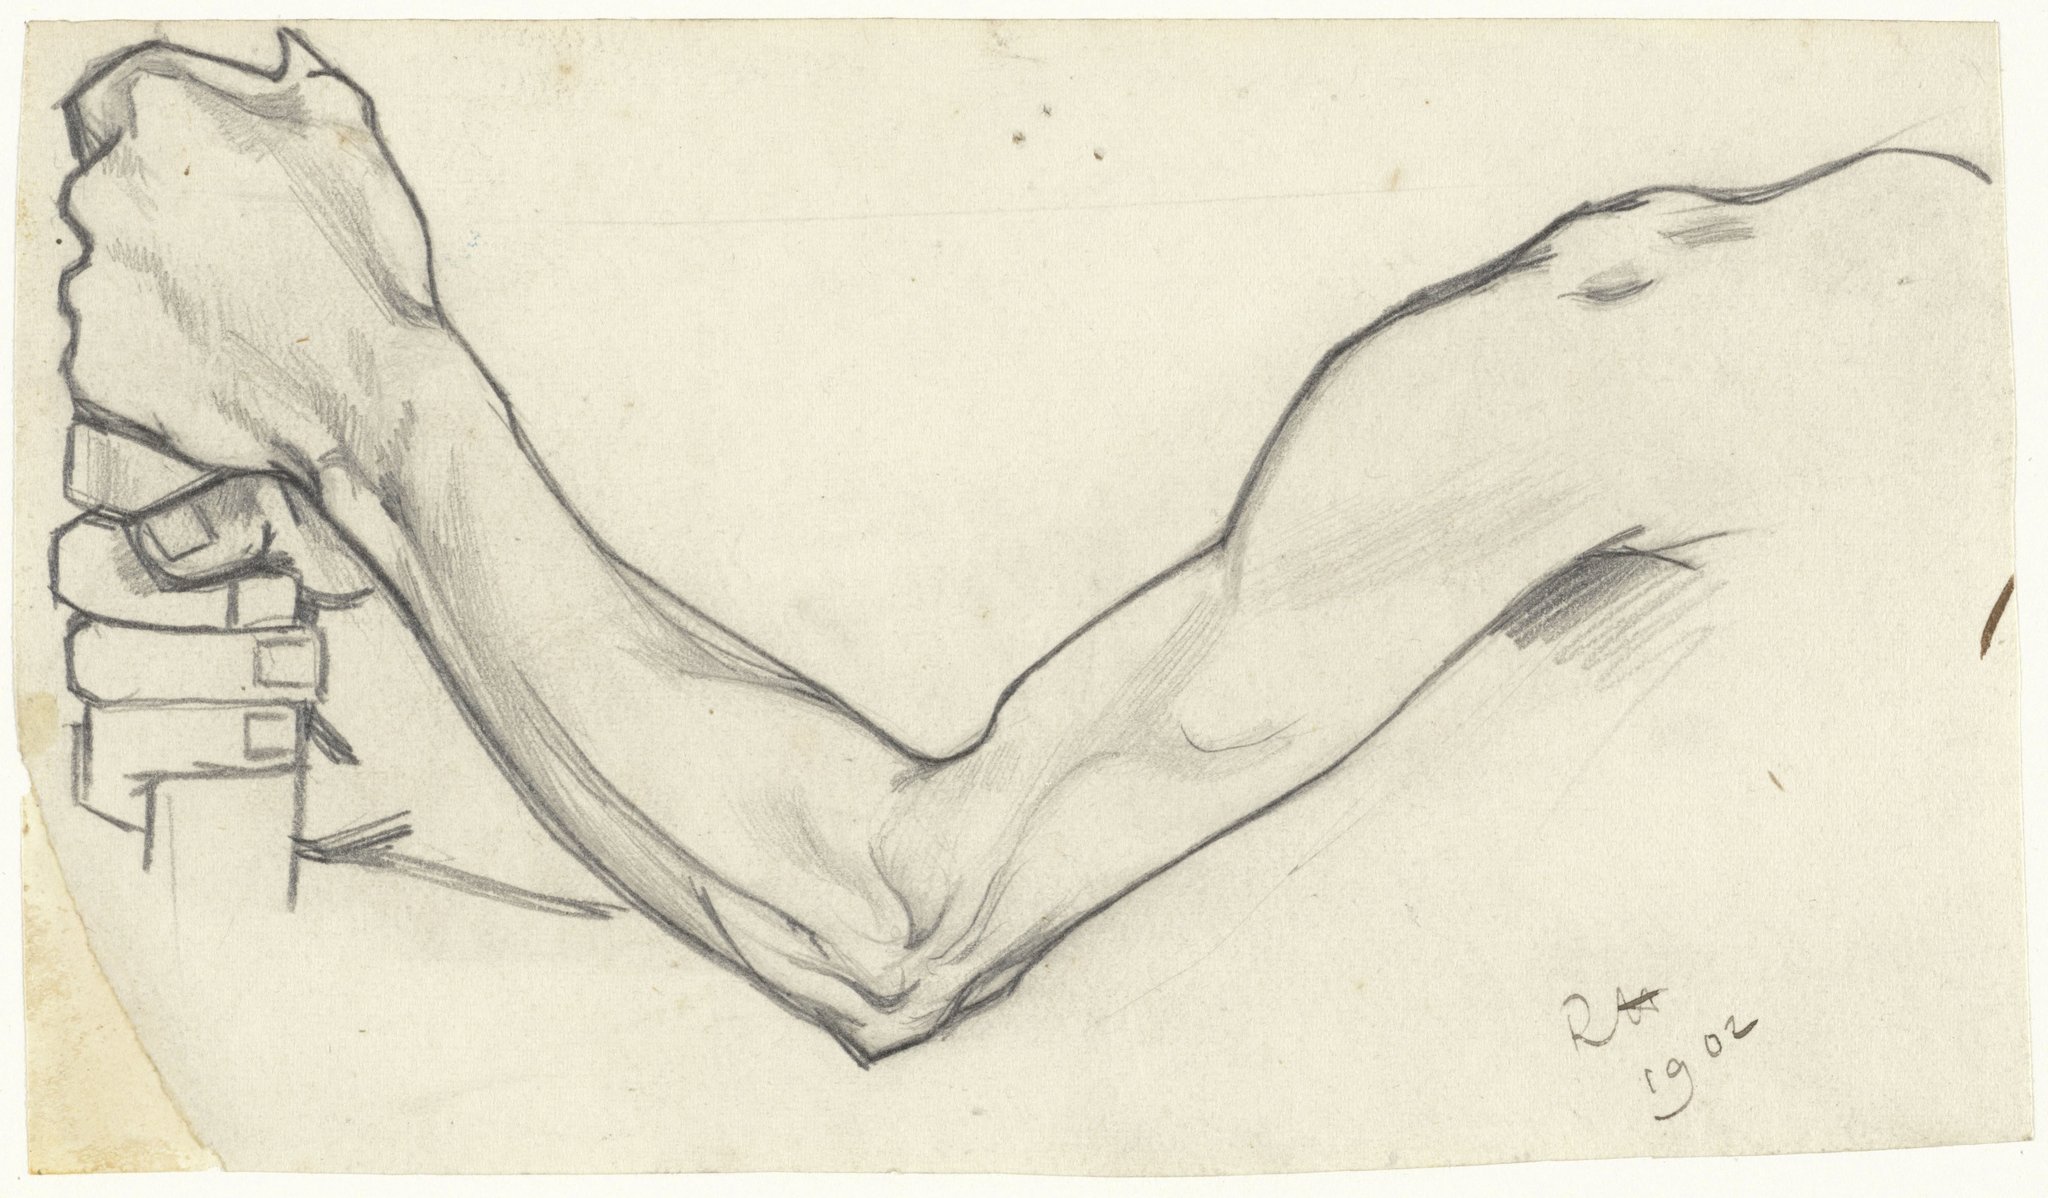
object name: drawing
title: Studie van een linkerarm die een stok vasthoudt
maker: richard nicolaüs roland holst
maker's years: 1868-1938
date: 1902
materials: paper, pencil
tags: arms